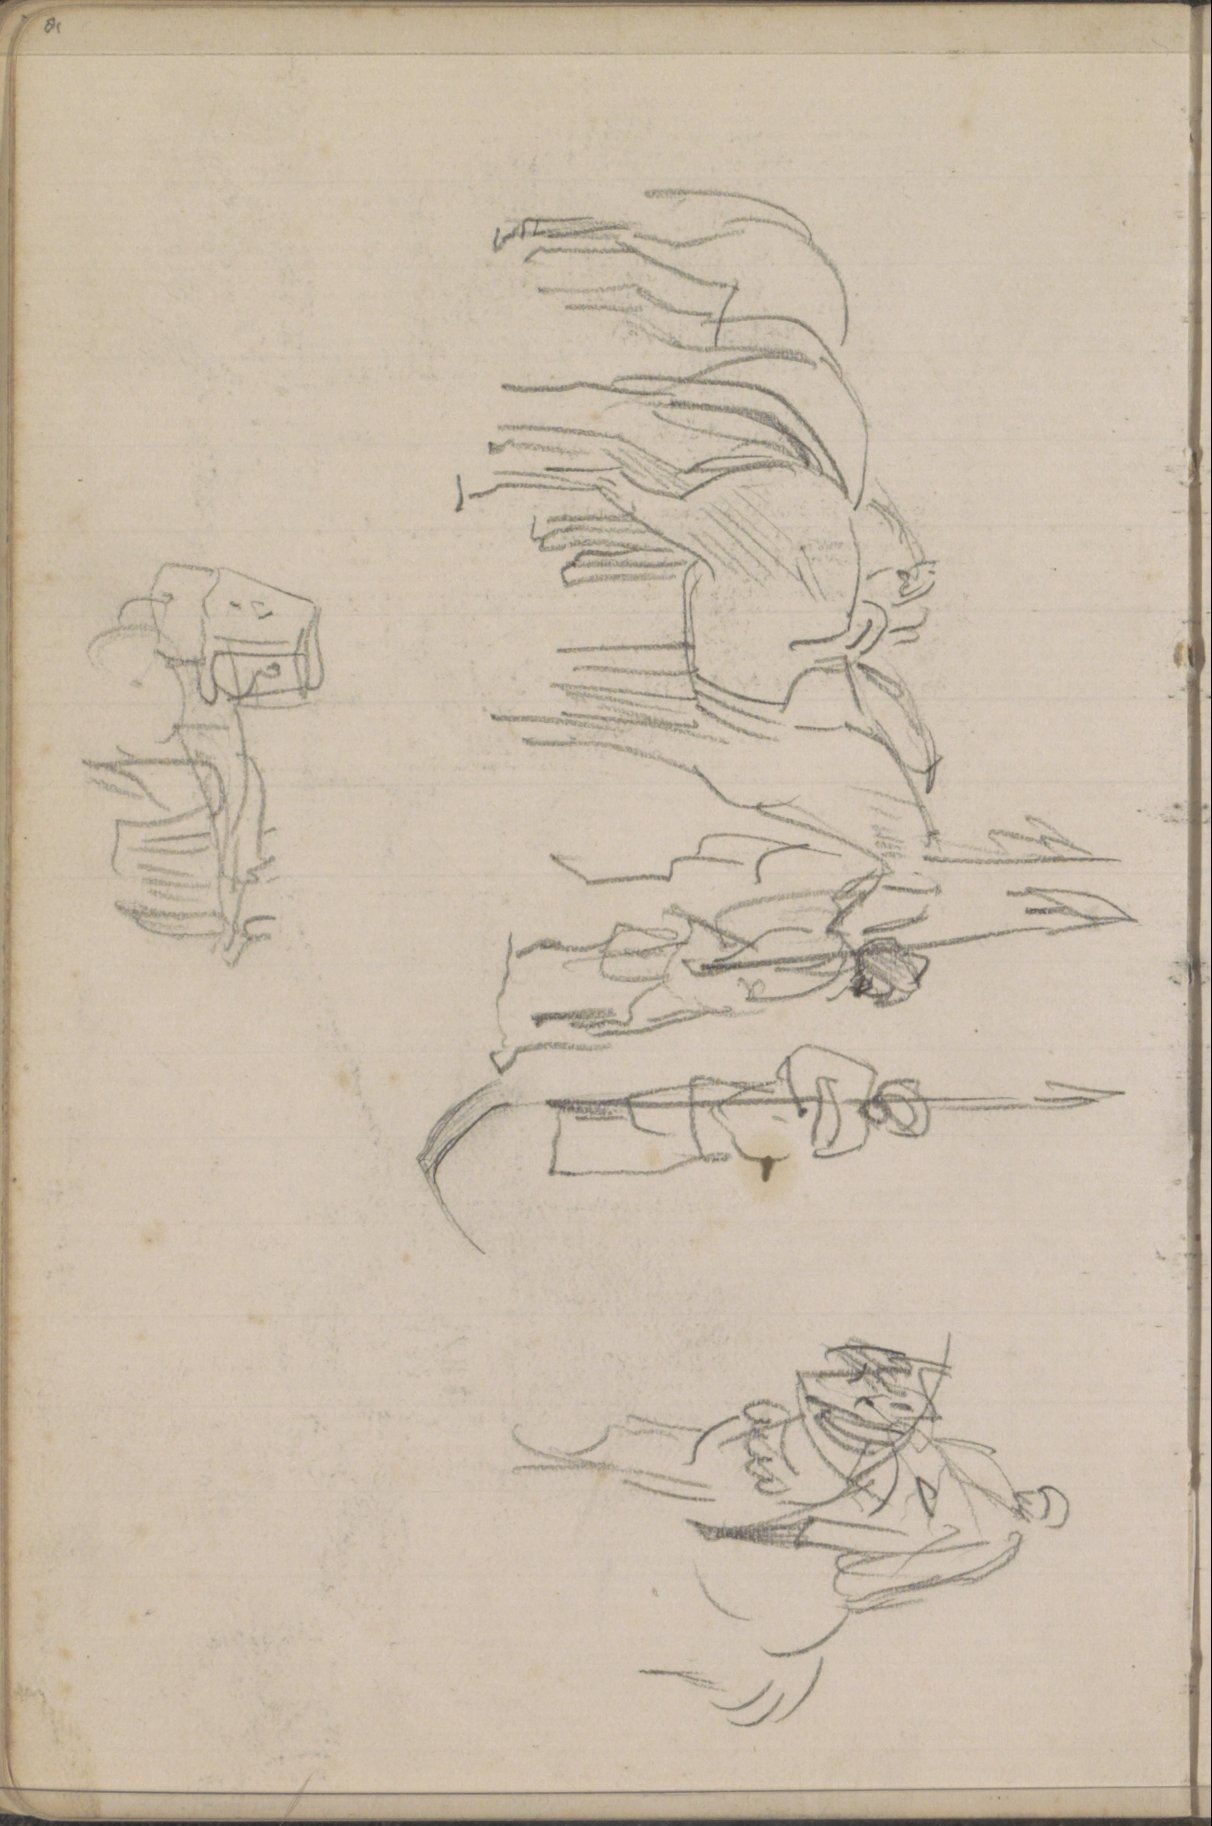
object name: sketchbook leaf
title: Indiërs met vlaggen en paarden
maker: marius bauer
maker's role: draughtsman, print maker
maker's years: 1867-1932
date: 1897-1898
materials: pencil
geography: india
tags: riding a horse, ass, or mule; rider, horseman, flags (~ signalling), asiatic races and peoples: indians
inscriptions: kleurnotitie, handgeschreven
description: Tevens een studie van een ruiter. Pagina 81 uit een schetsboek met 84 bladen.